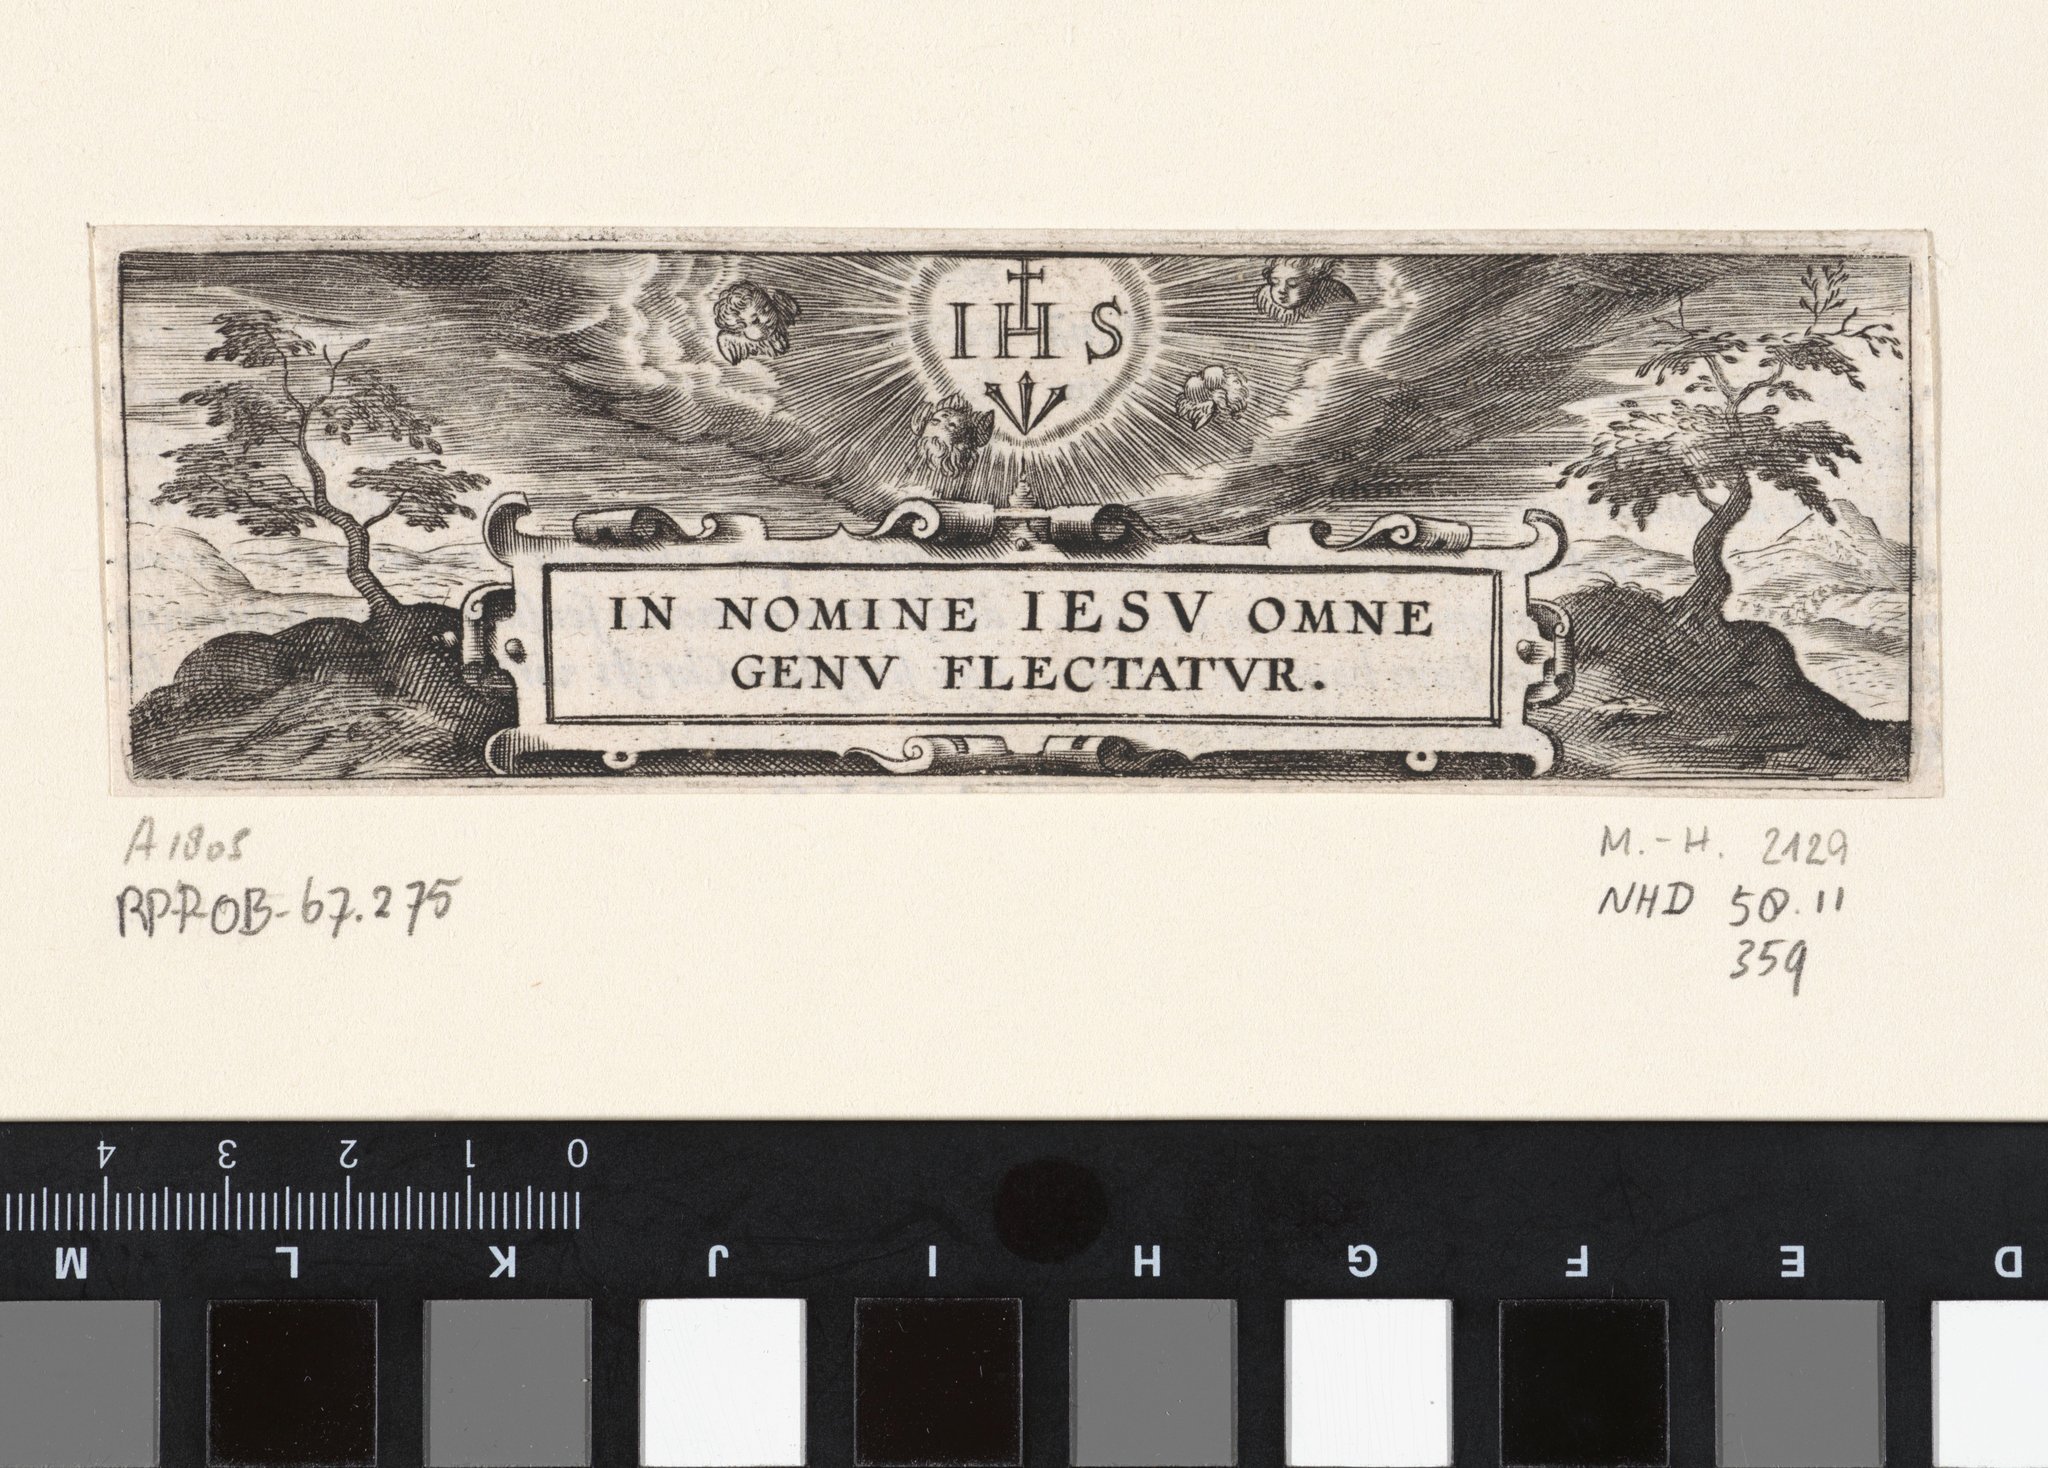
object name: print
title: In Nomine Iesv Omne Genv Flectatvr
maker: wierix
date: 1594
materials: paper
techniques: engraving, letterpress printing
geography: antwerp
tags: ihs ('iesus hominum salvator') ~ symbol of christ (+ angel(s))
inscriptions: collector's mark: Lugt 2165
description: Prent gebruikt in: Nadal, Jerónimo. Adnotationes et Meditationes. Antwerpen: Martinus Nutius, 1594.